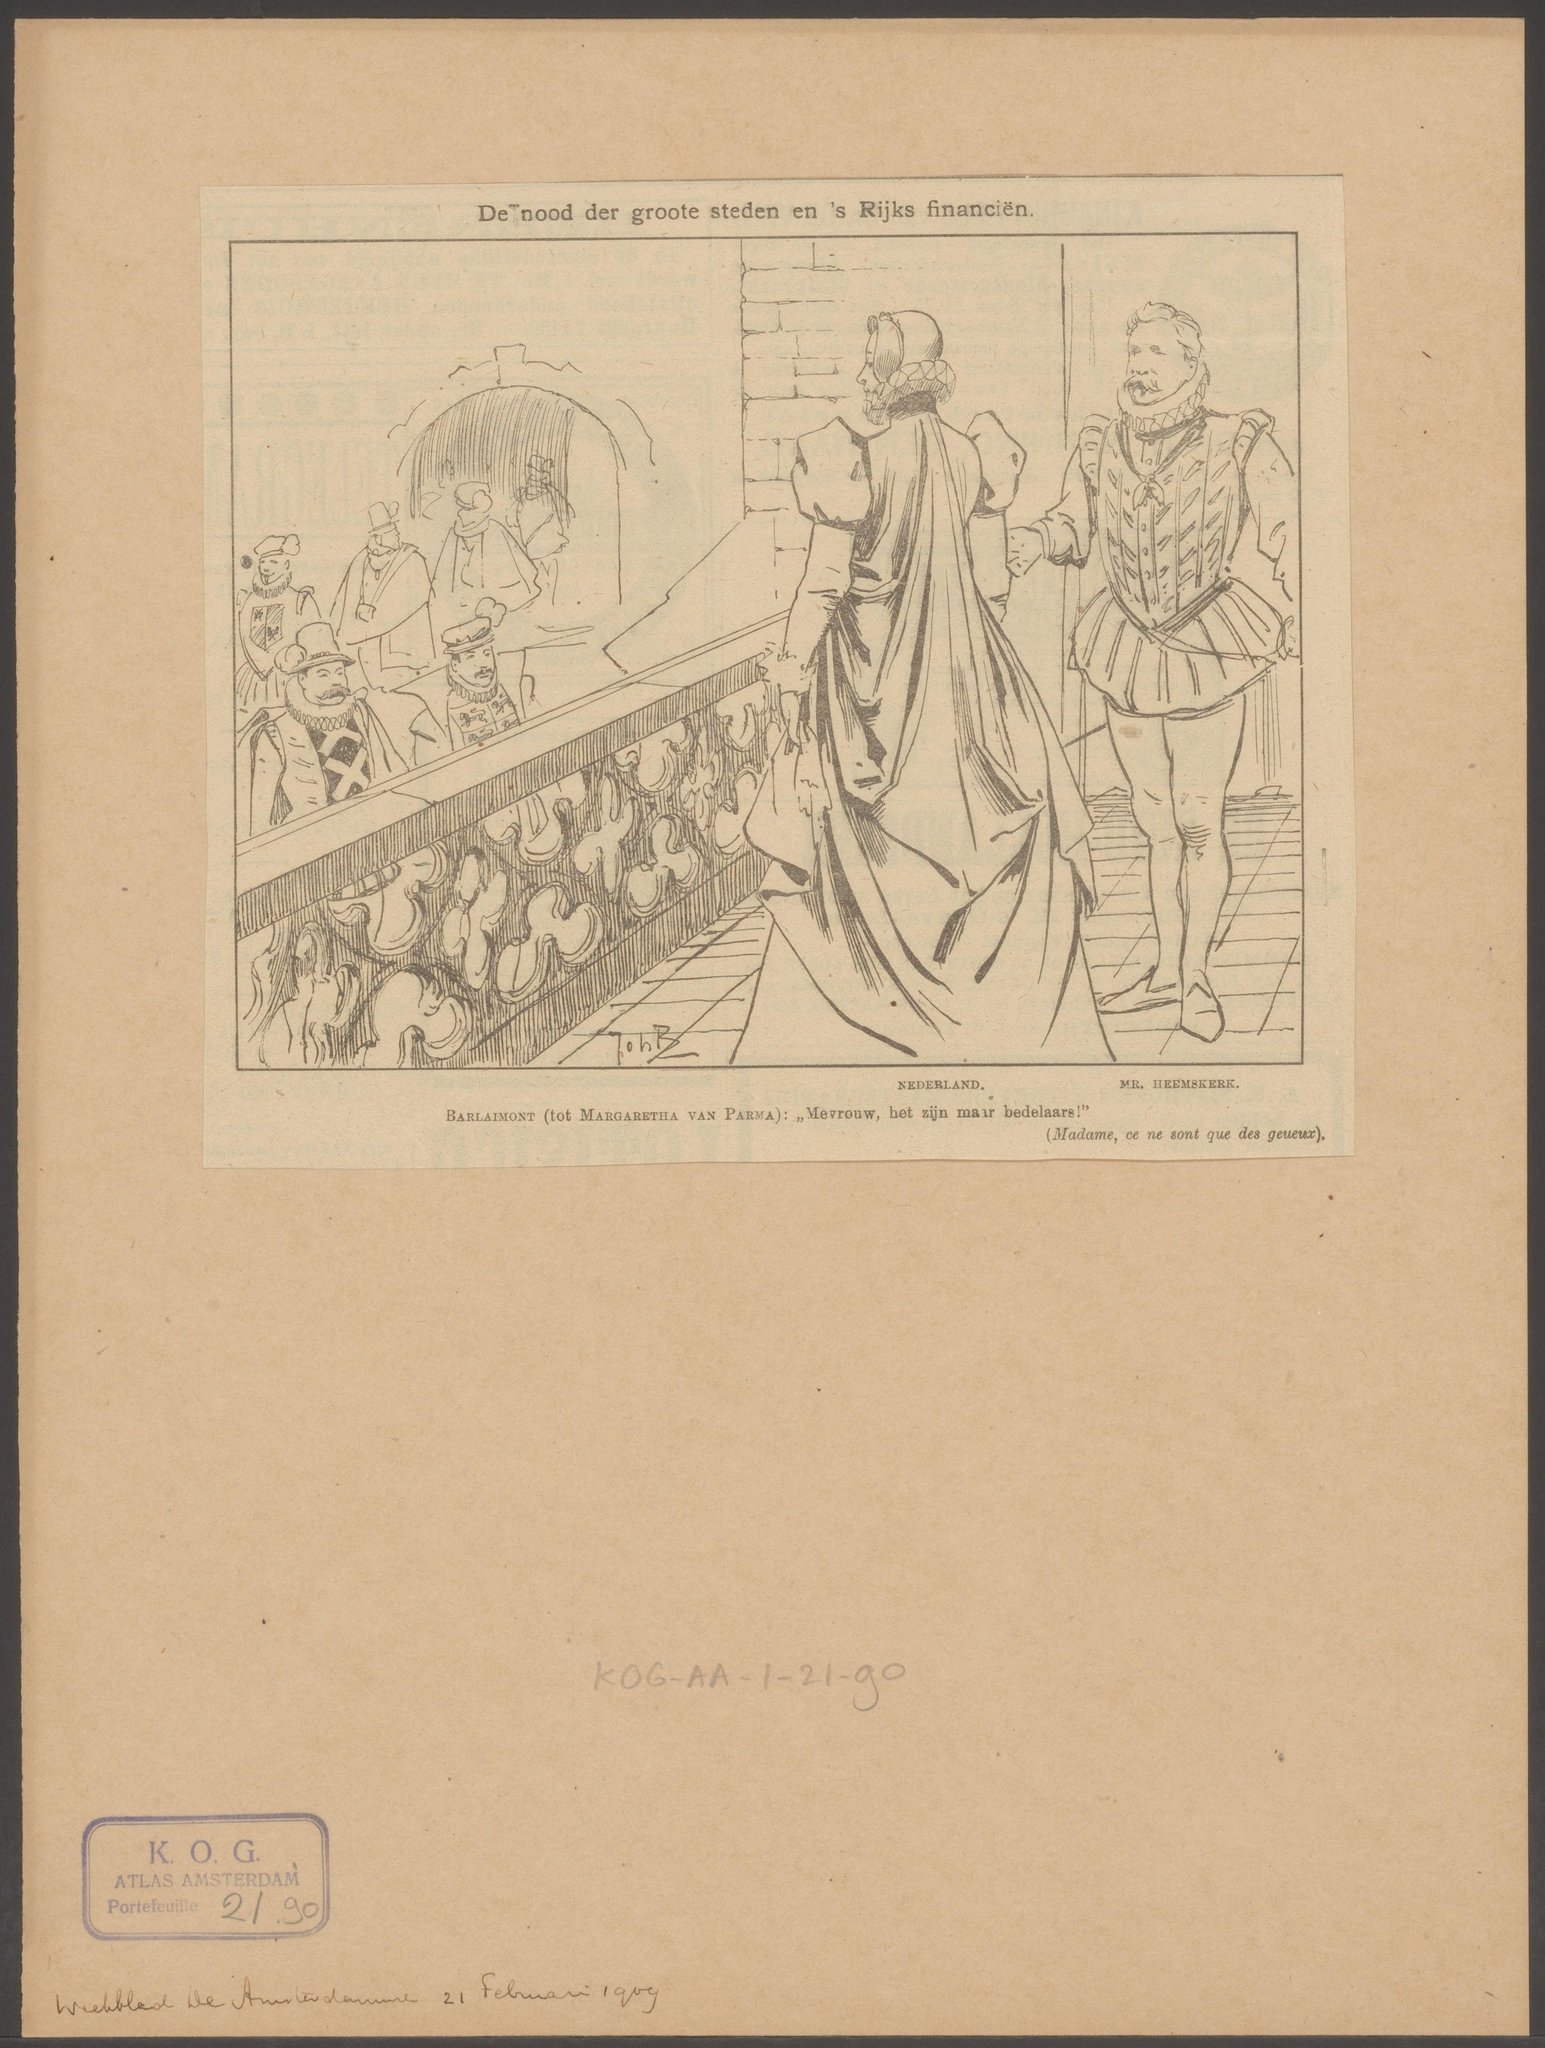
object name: photomechanical print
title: De nood der groote steden en 's Rijks financiën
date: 1909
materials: paper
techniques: letterpress printing, line block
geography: netherlands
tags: utrecht, coat of arms (symbol of sovereignty), personification of a city, town-patron(ess), ruler, sovereign - bb - female ruler, politician, e.g. party leader, political caricatures and satires, amsterdam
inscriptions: inscription: ‘Weekblad De Amsterdammer 21 februari 1909’, collector's mark: Lugt 1641b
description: Margaretha van Parma afgebeeld als personificatie van Nederland, premier Theodorus Heemskerk als Charles de Berlaymont, en mannen met stadswapens als steden. Onderwerpsrubriek binnen de Atlas Amsterdam: Financiën.